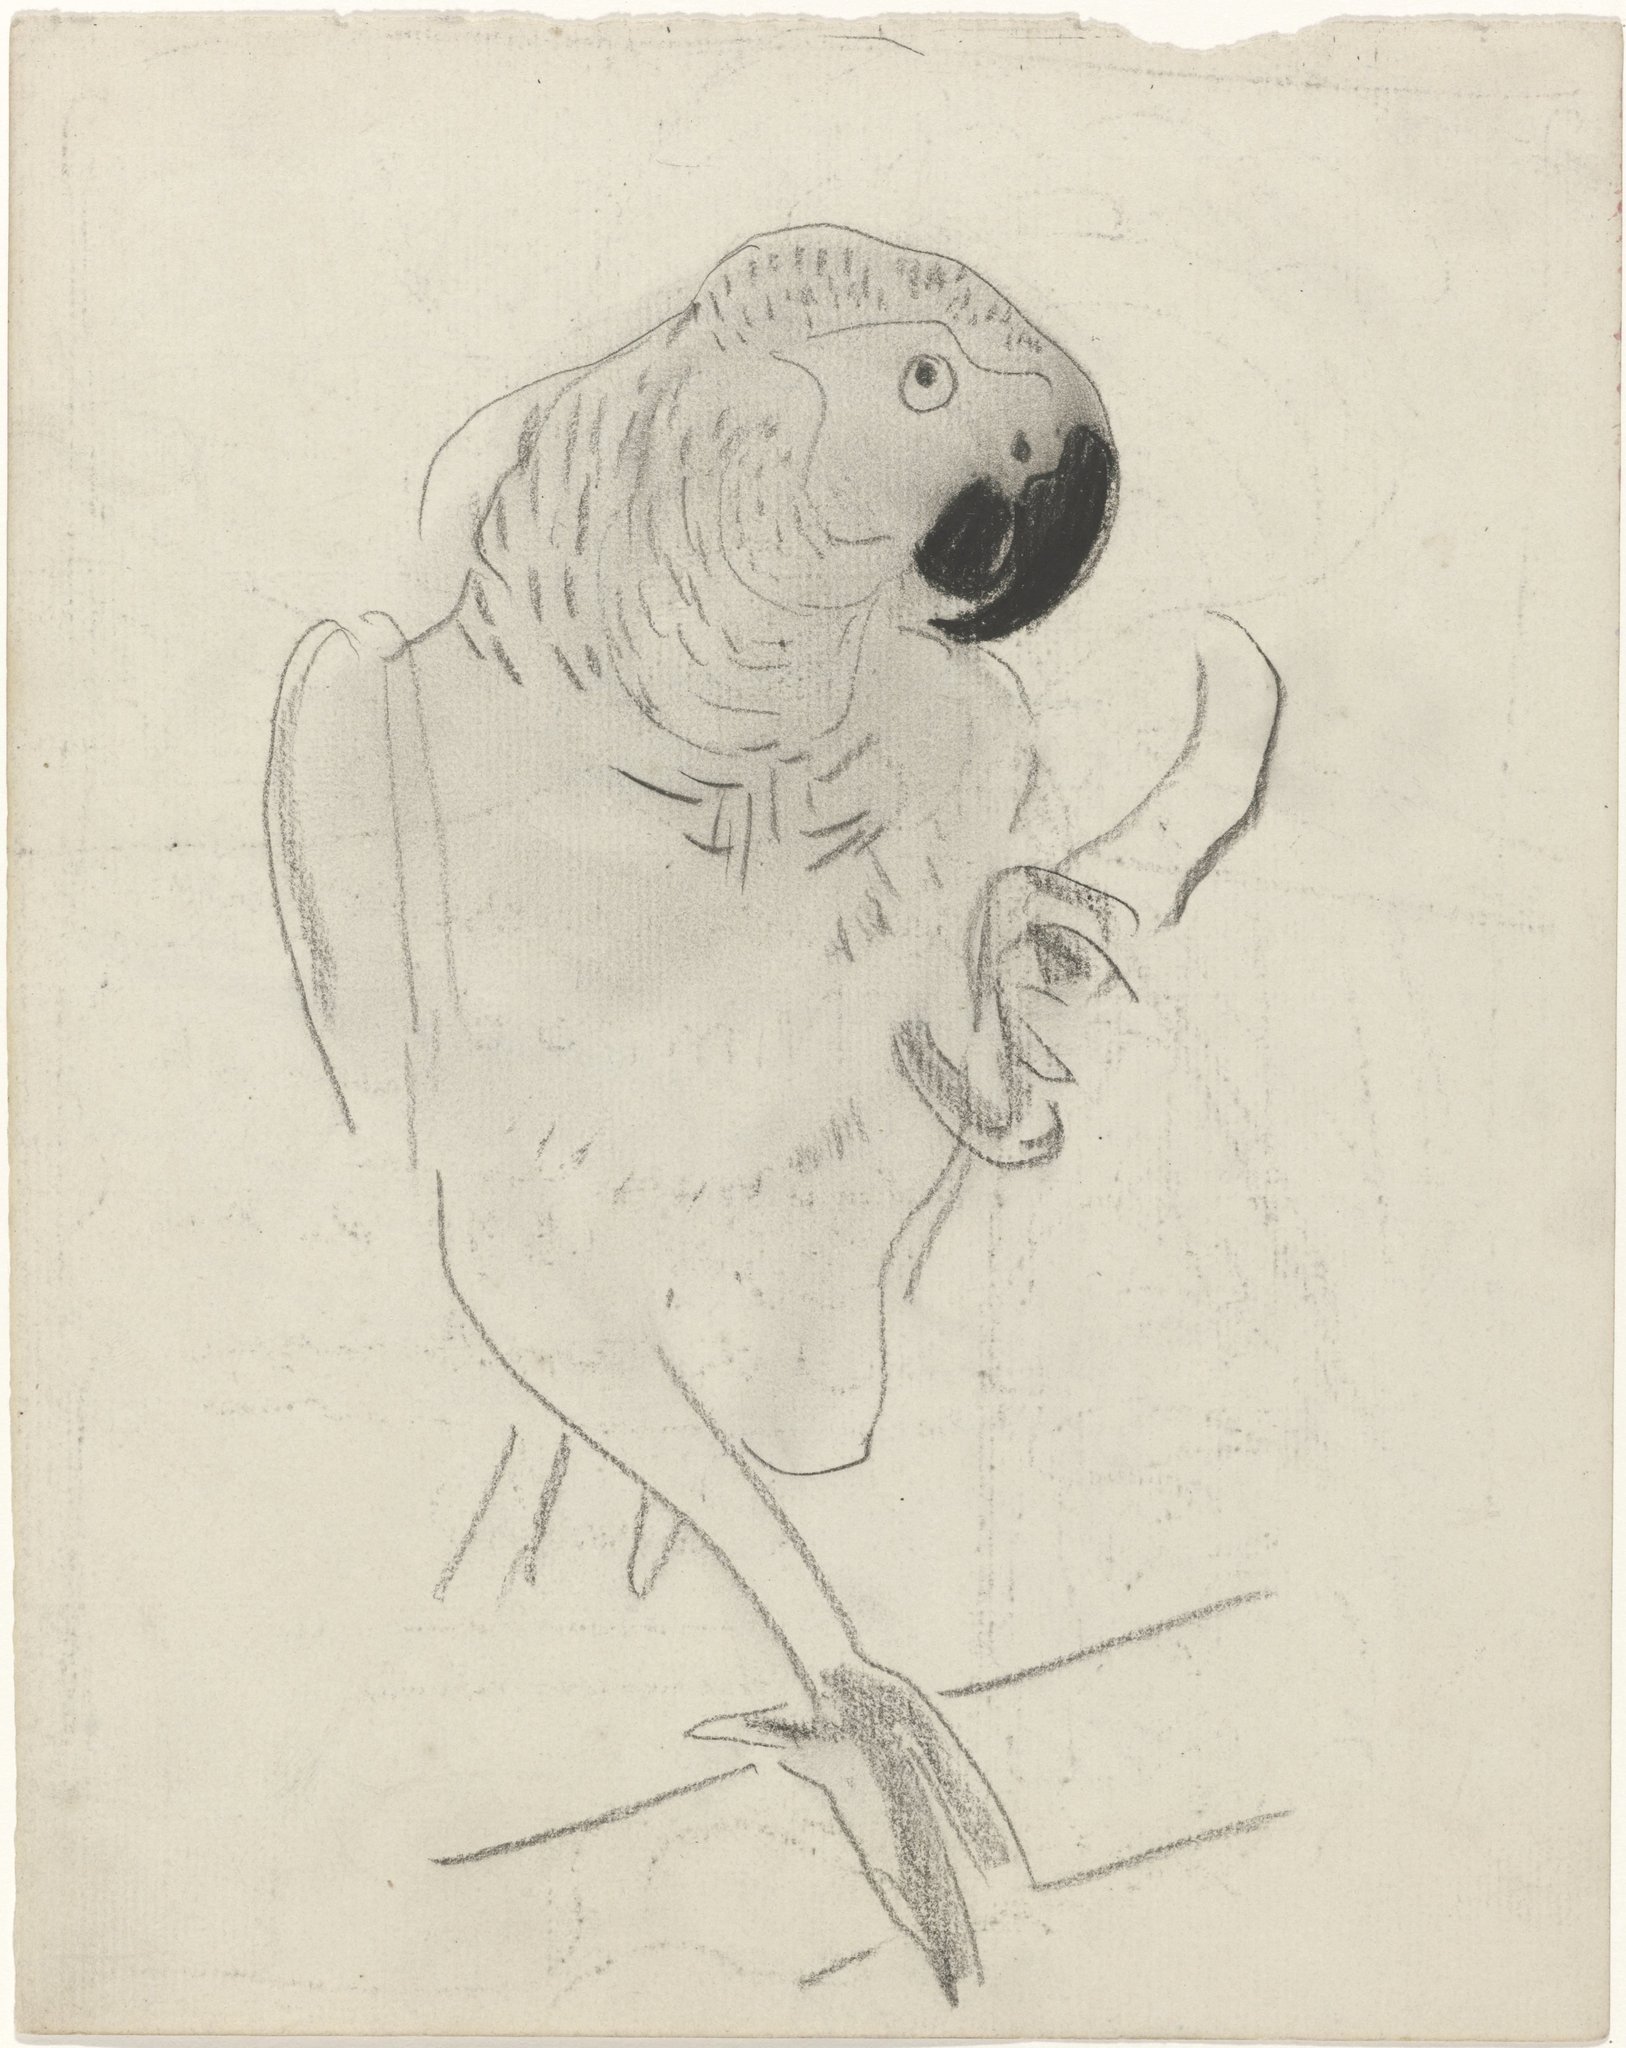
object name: drawing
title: Papegaai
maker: carel adolph lion cachet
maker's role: draughtsman, print maker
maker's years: 1864-1945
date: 1874-1945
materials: chalk, paper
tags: ornamental birds: parrot